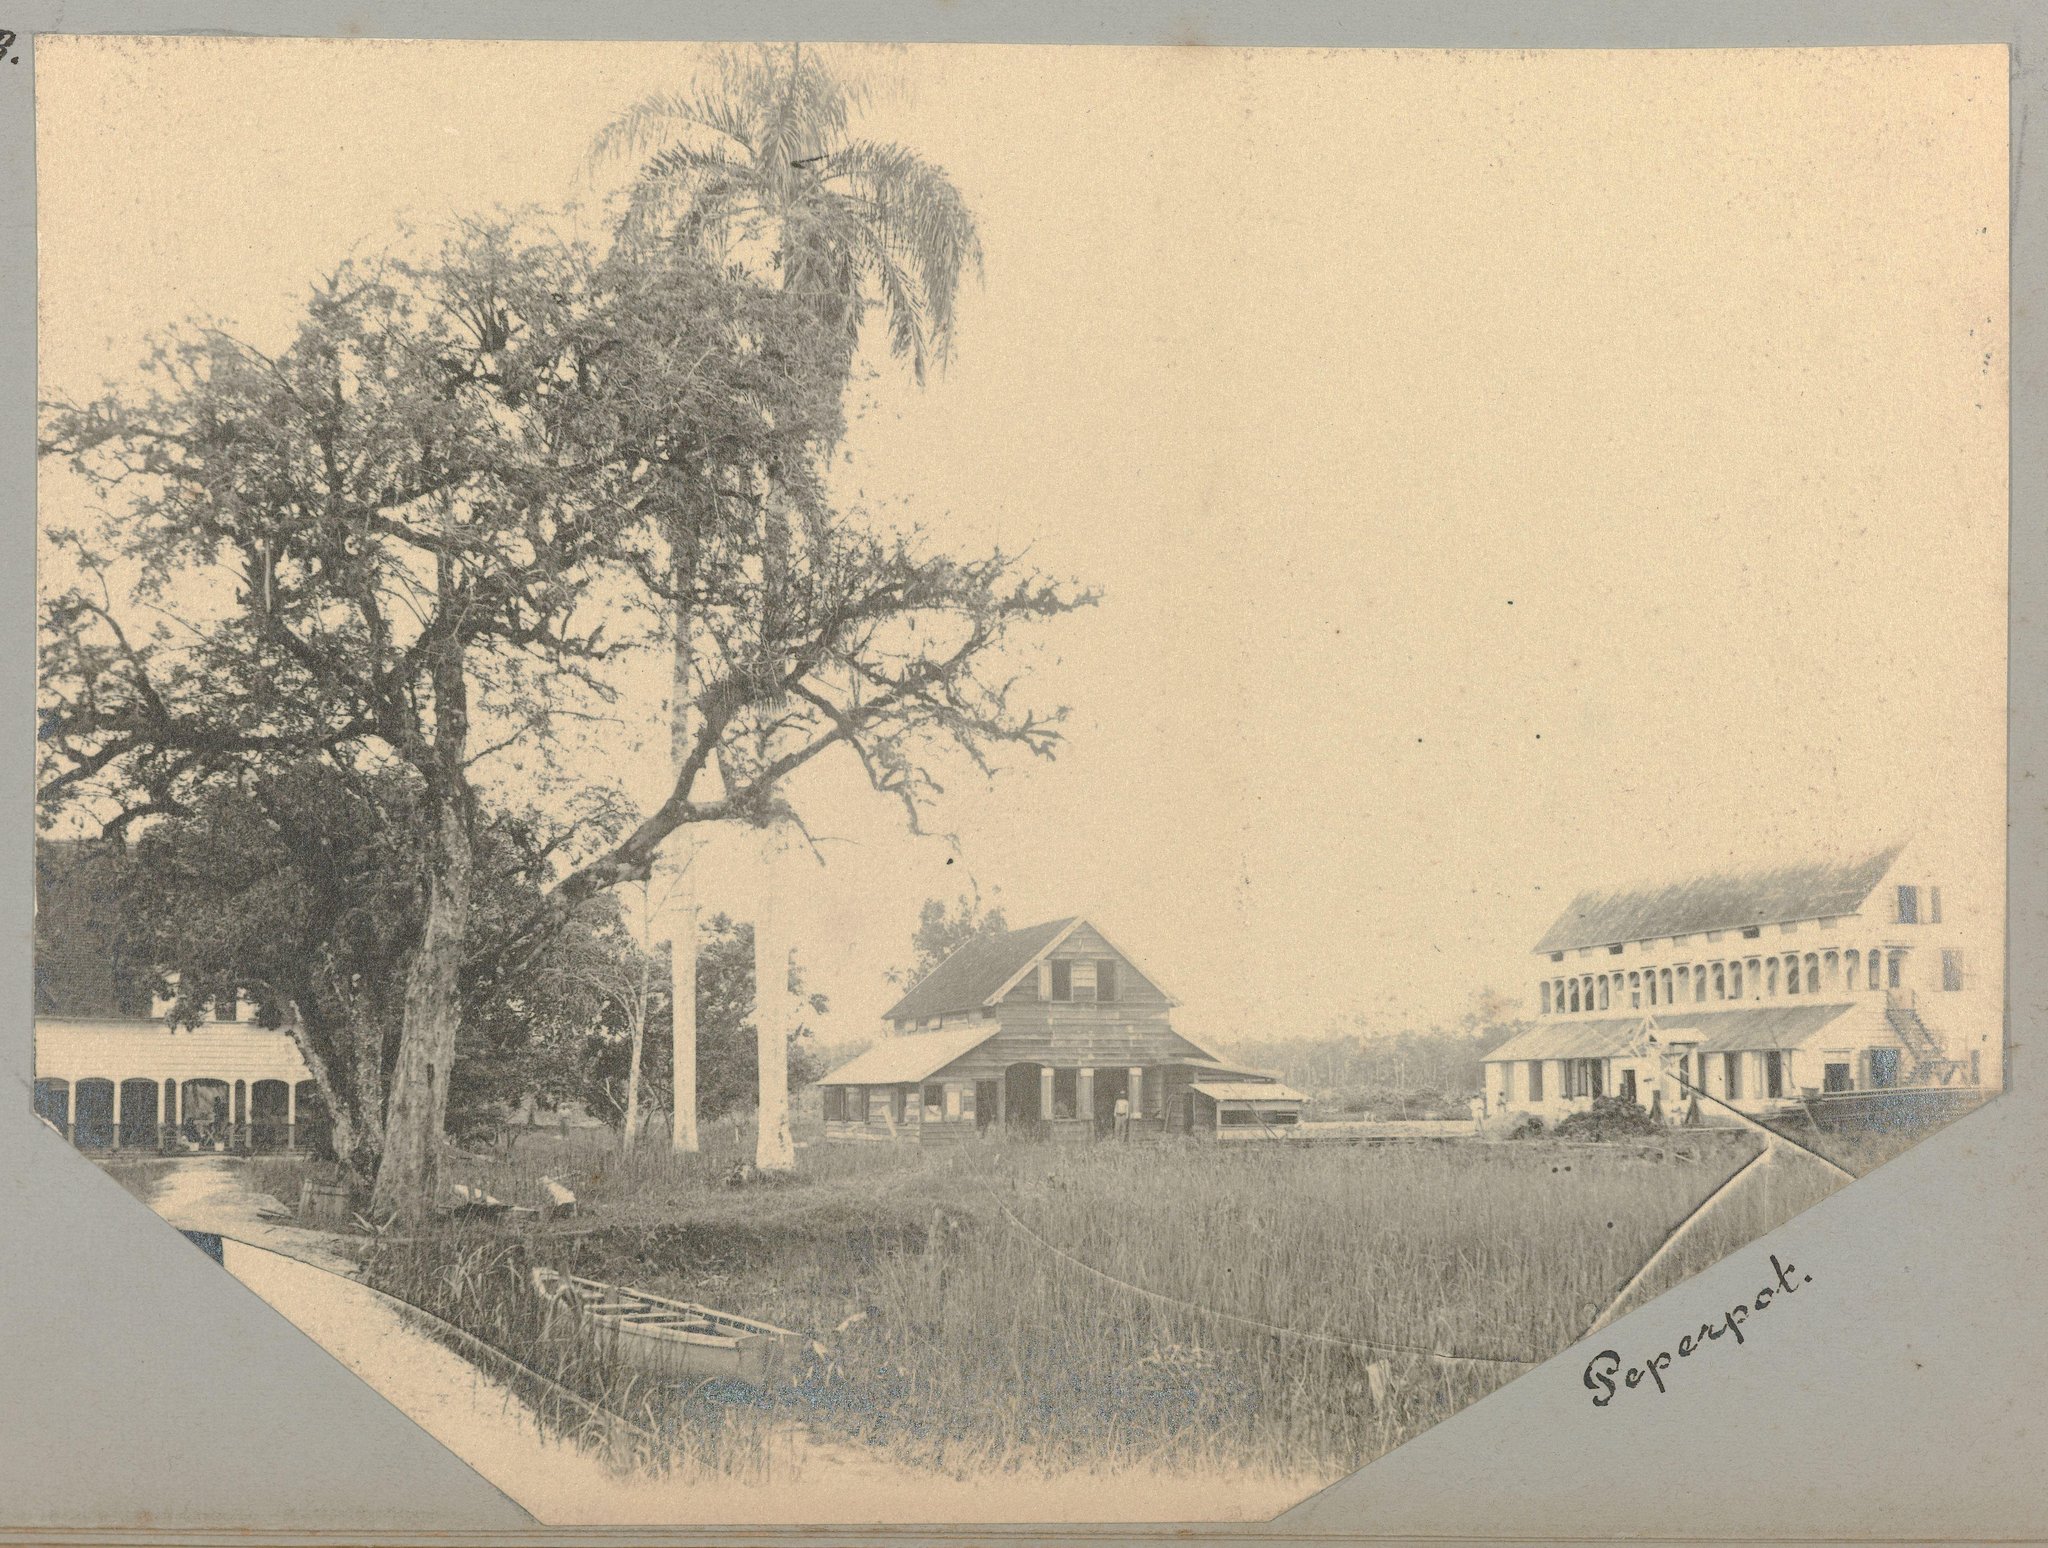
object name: photograph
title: Peperpot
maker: gomez burke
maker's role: fotograaf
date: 1891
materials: photographic support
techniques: gelatin silver print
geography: suriname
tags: suriname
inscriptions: inscription: ‘G.B. / Peperpot.’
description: Gezicht op de huizen op de Plantage Peperpot. Onderdeel van het fotoalbum Souvenir de Voyage (deel 4), over het leven van de familie Dooyer in en rond de plantage Ma Retraite in Suriname in de jaren 1906-1913.